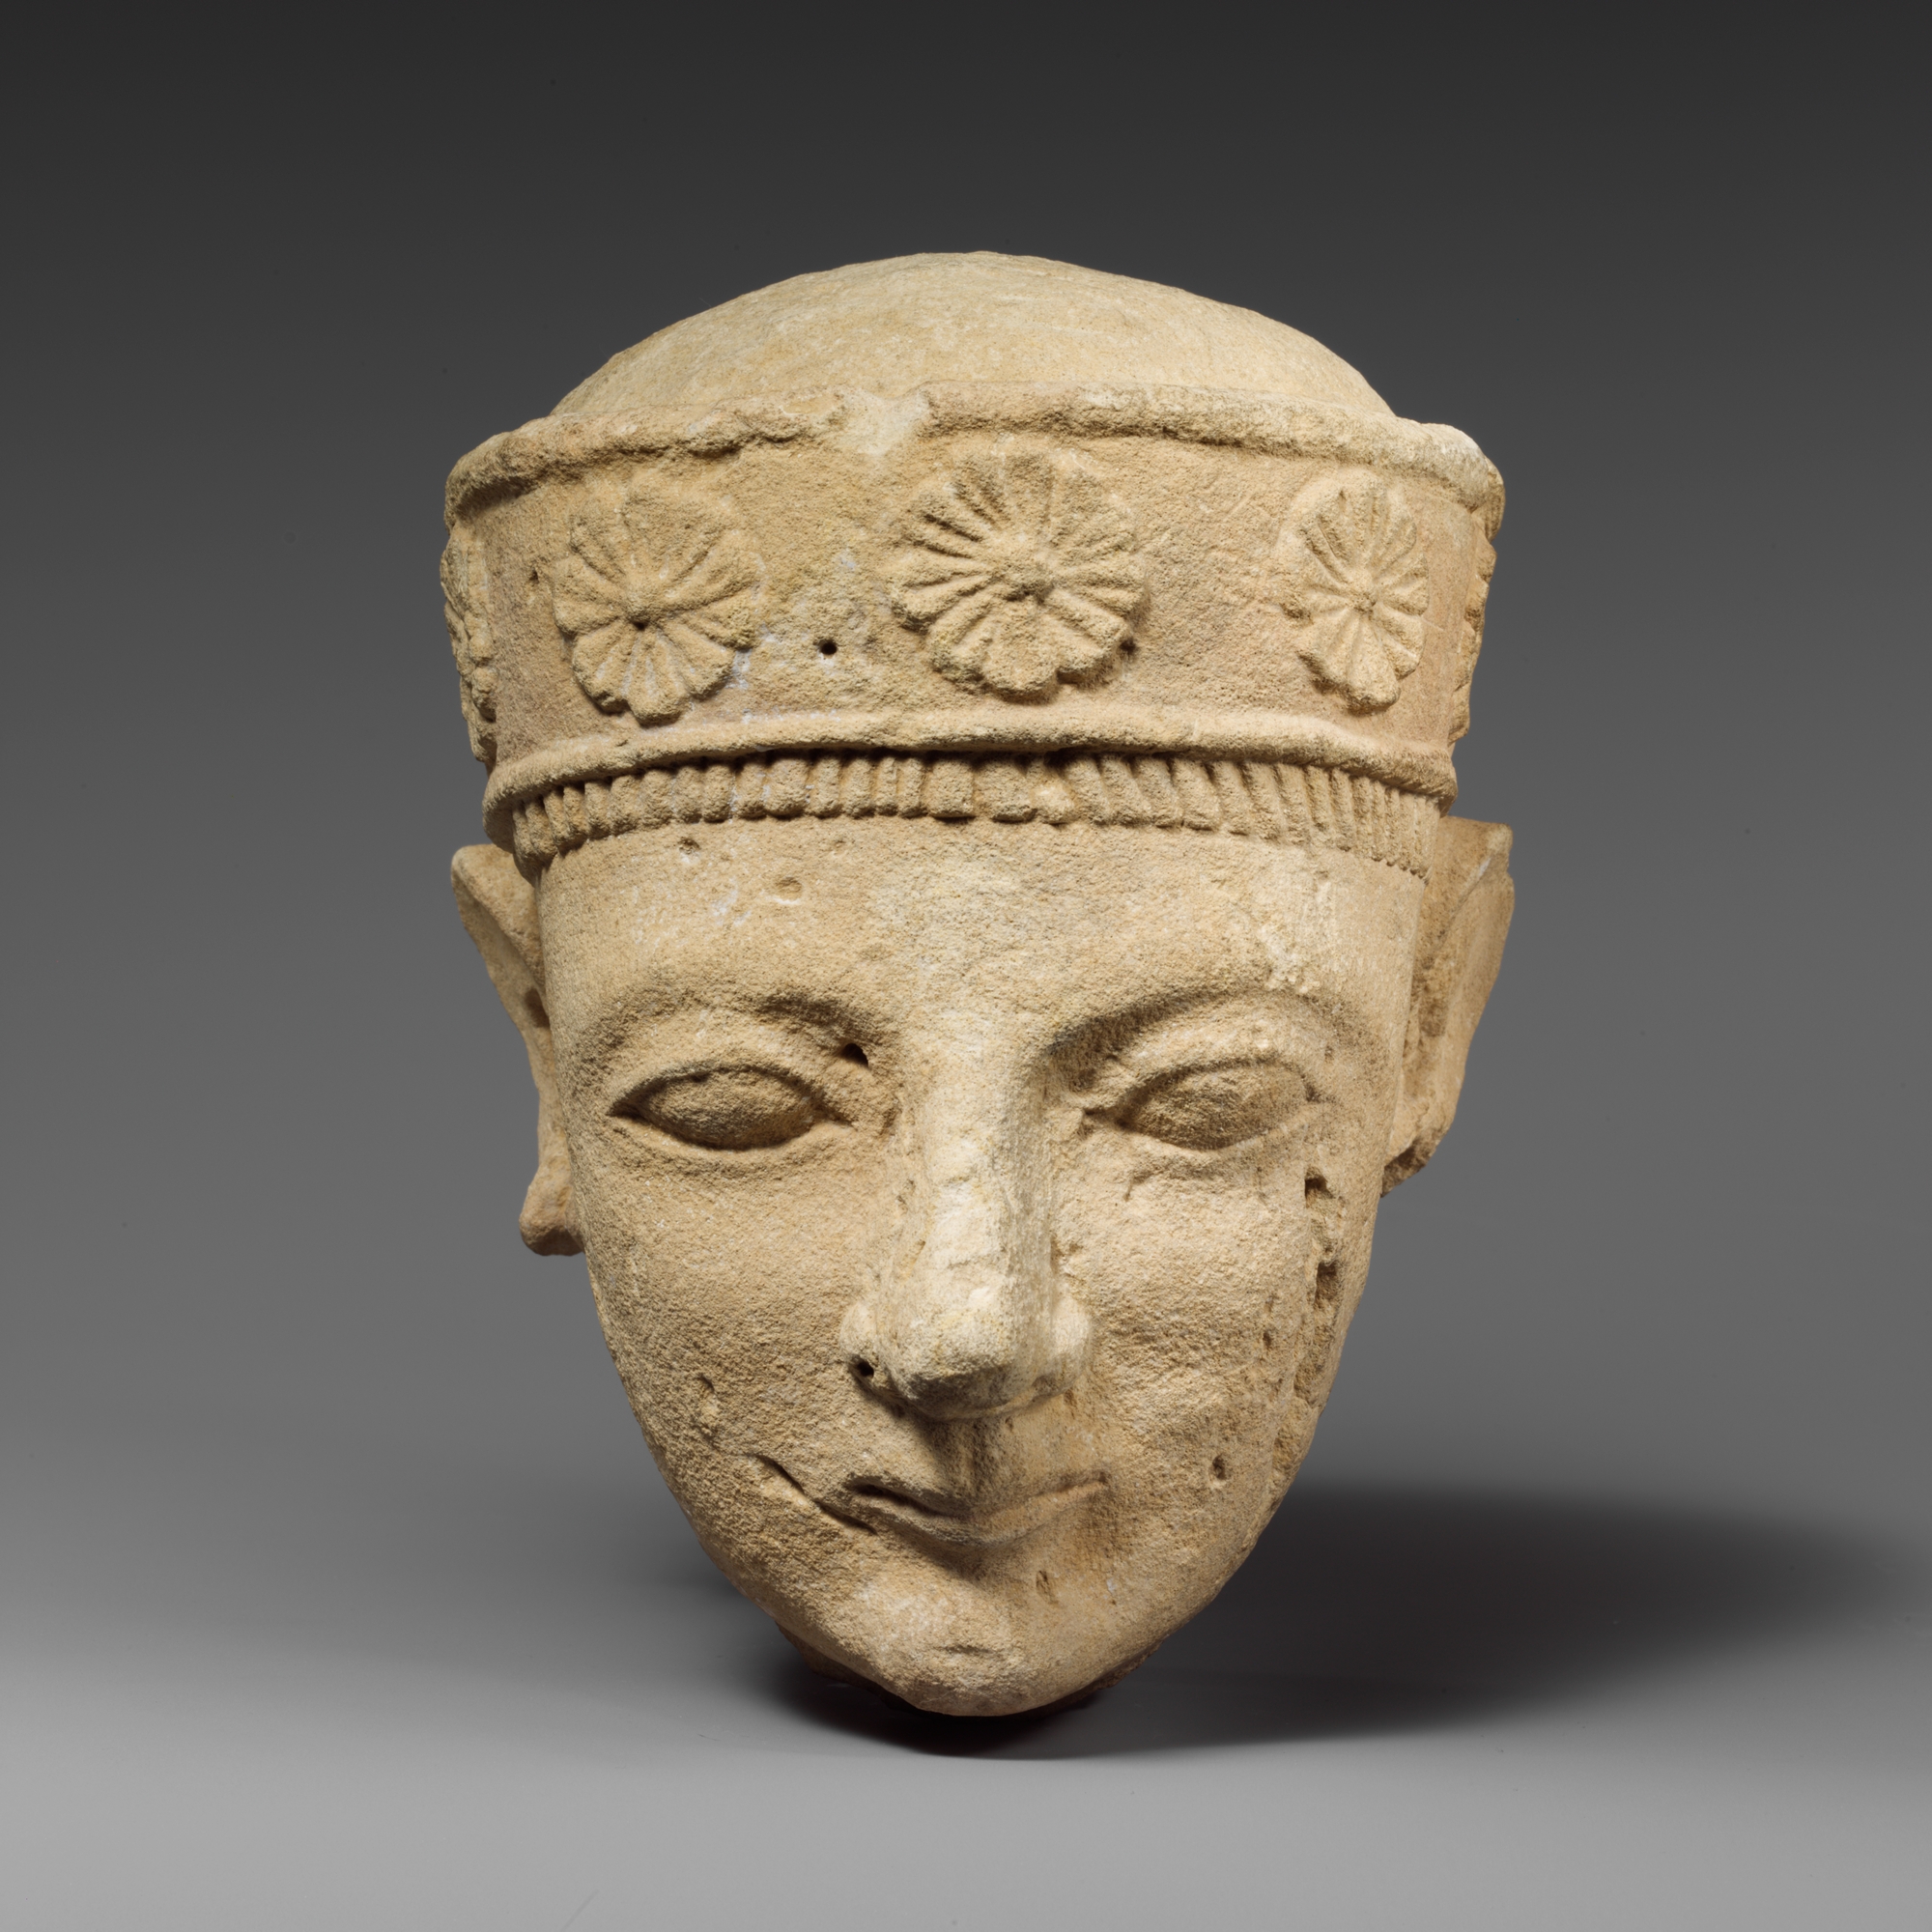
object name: head of a votary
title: Limestone head of a beardless male with a diadem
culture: cypriot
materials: limestone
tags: diadems,earrings,heads,men